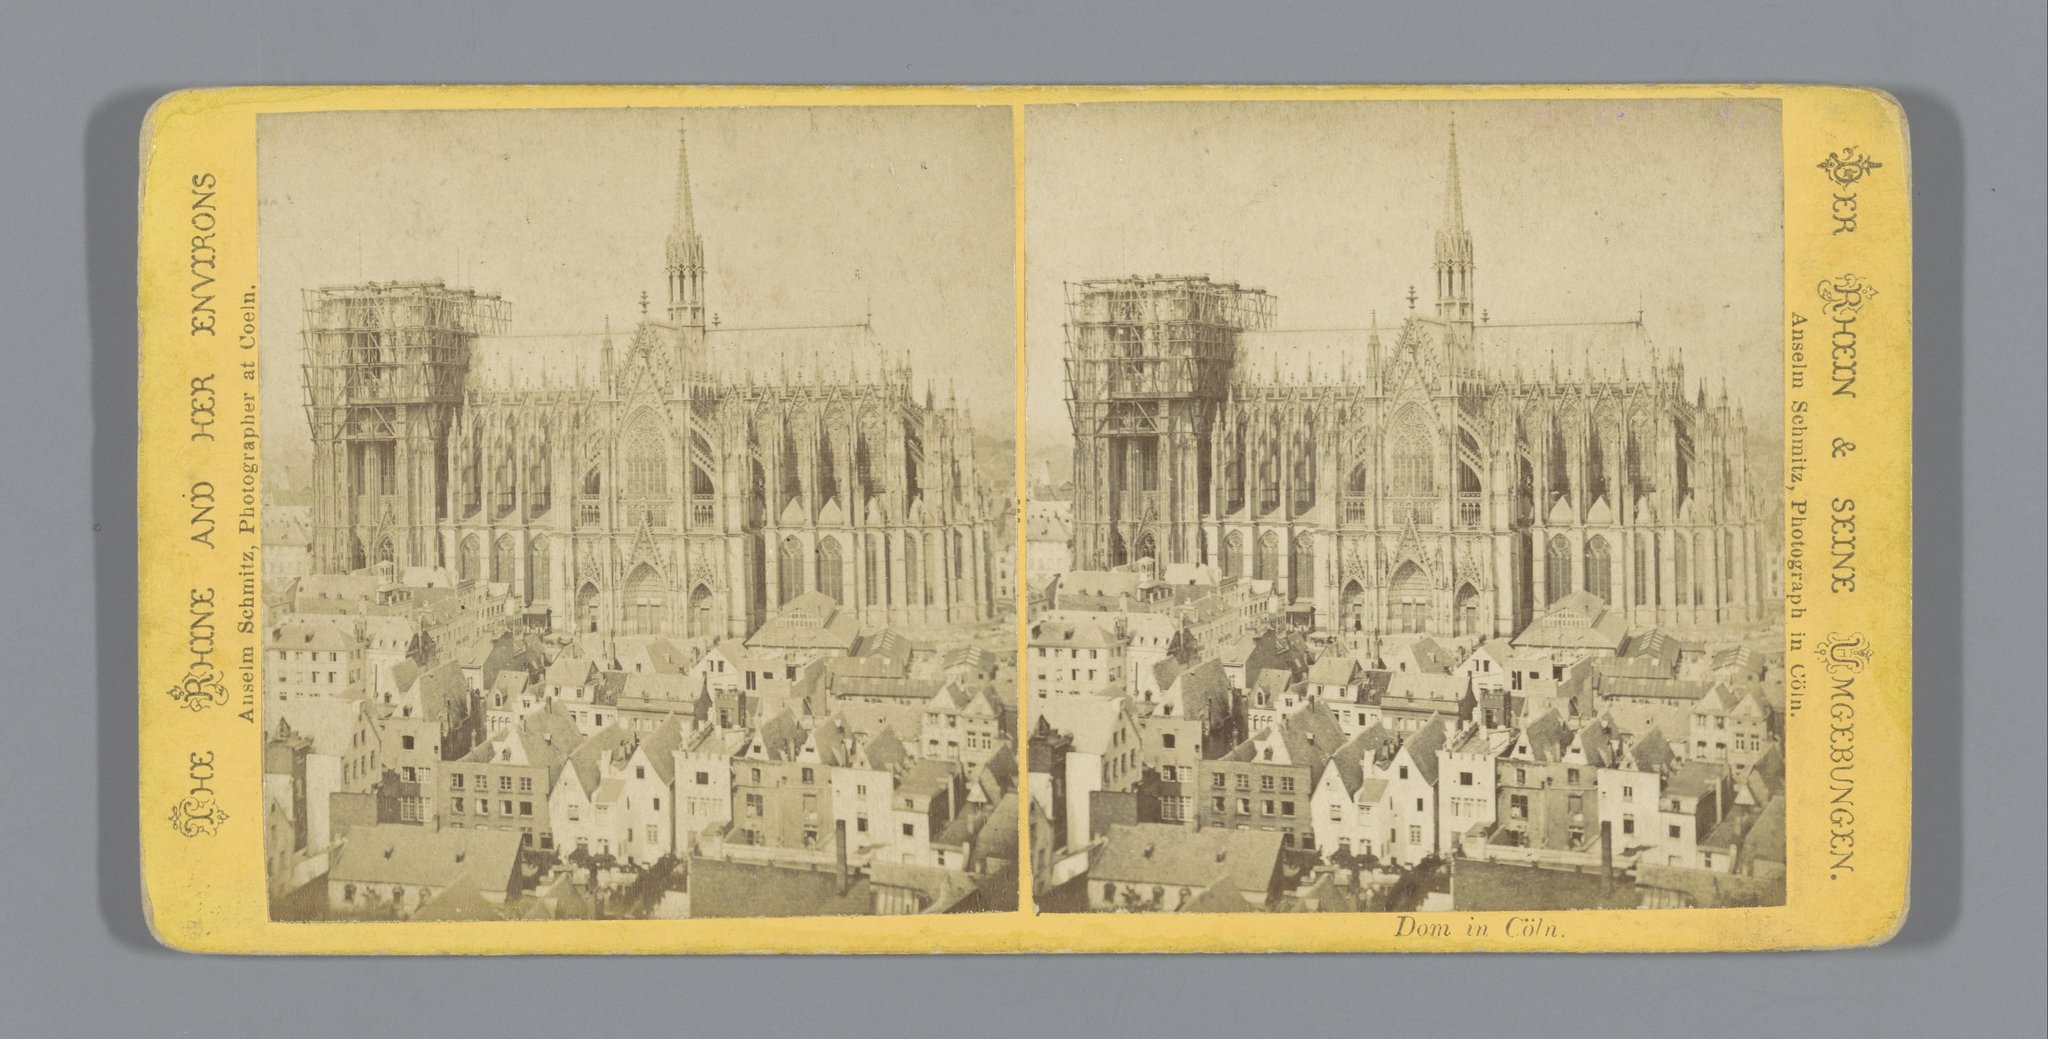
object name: stereograph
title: Dom in Cöln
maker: anselm schmitz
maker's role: publisher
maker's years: 1831-1903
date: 1865-1875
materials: cardboard, photographic support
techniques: albumen print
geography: cologne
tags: church (exterior), façade (of house or building)